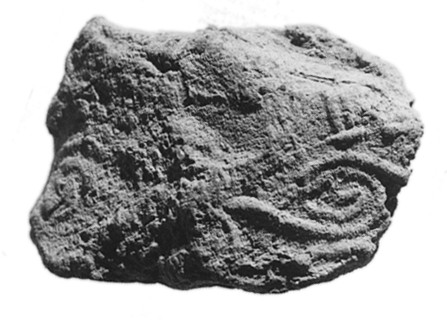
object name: sealing fragment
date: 2030-1640 BCE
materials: clay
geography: egypt